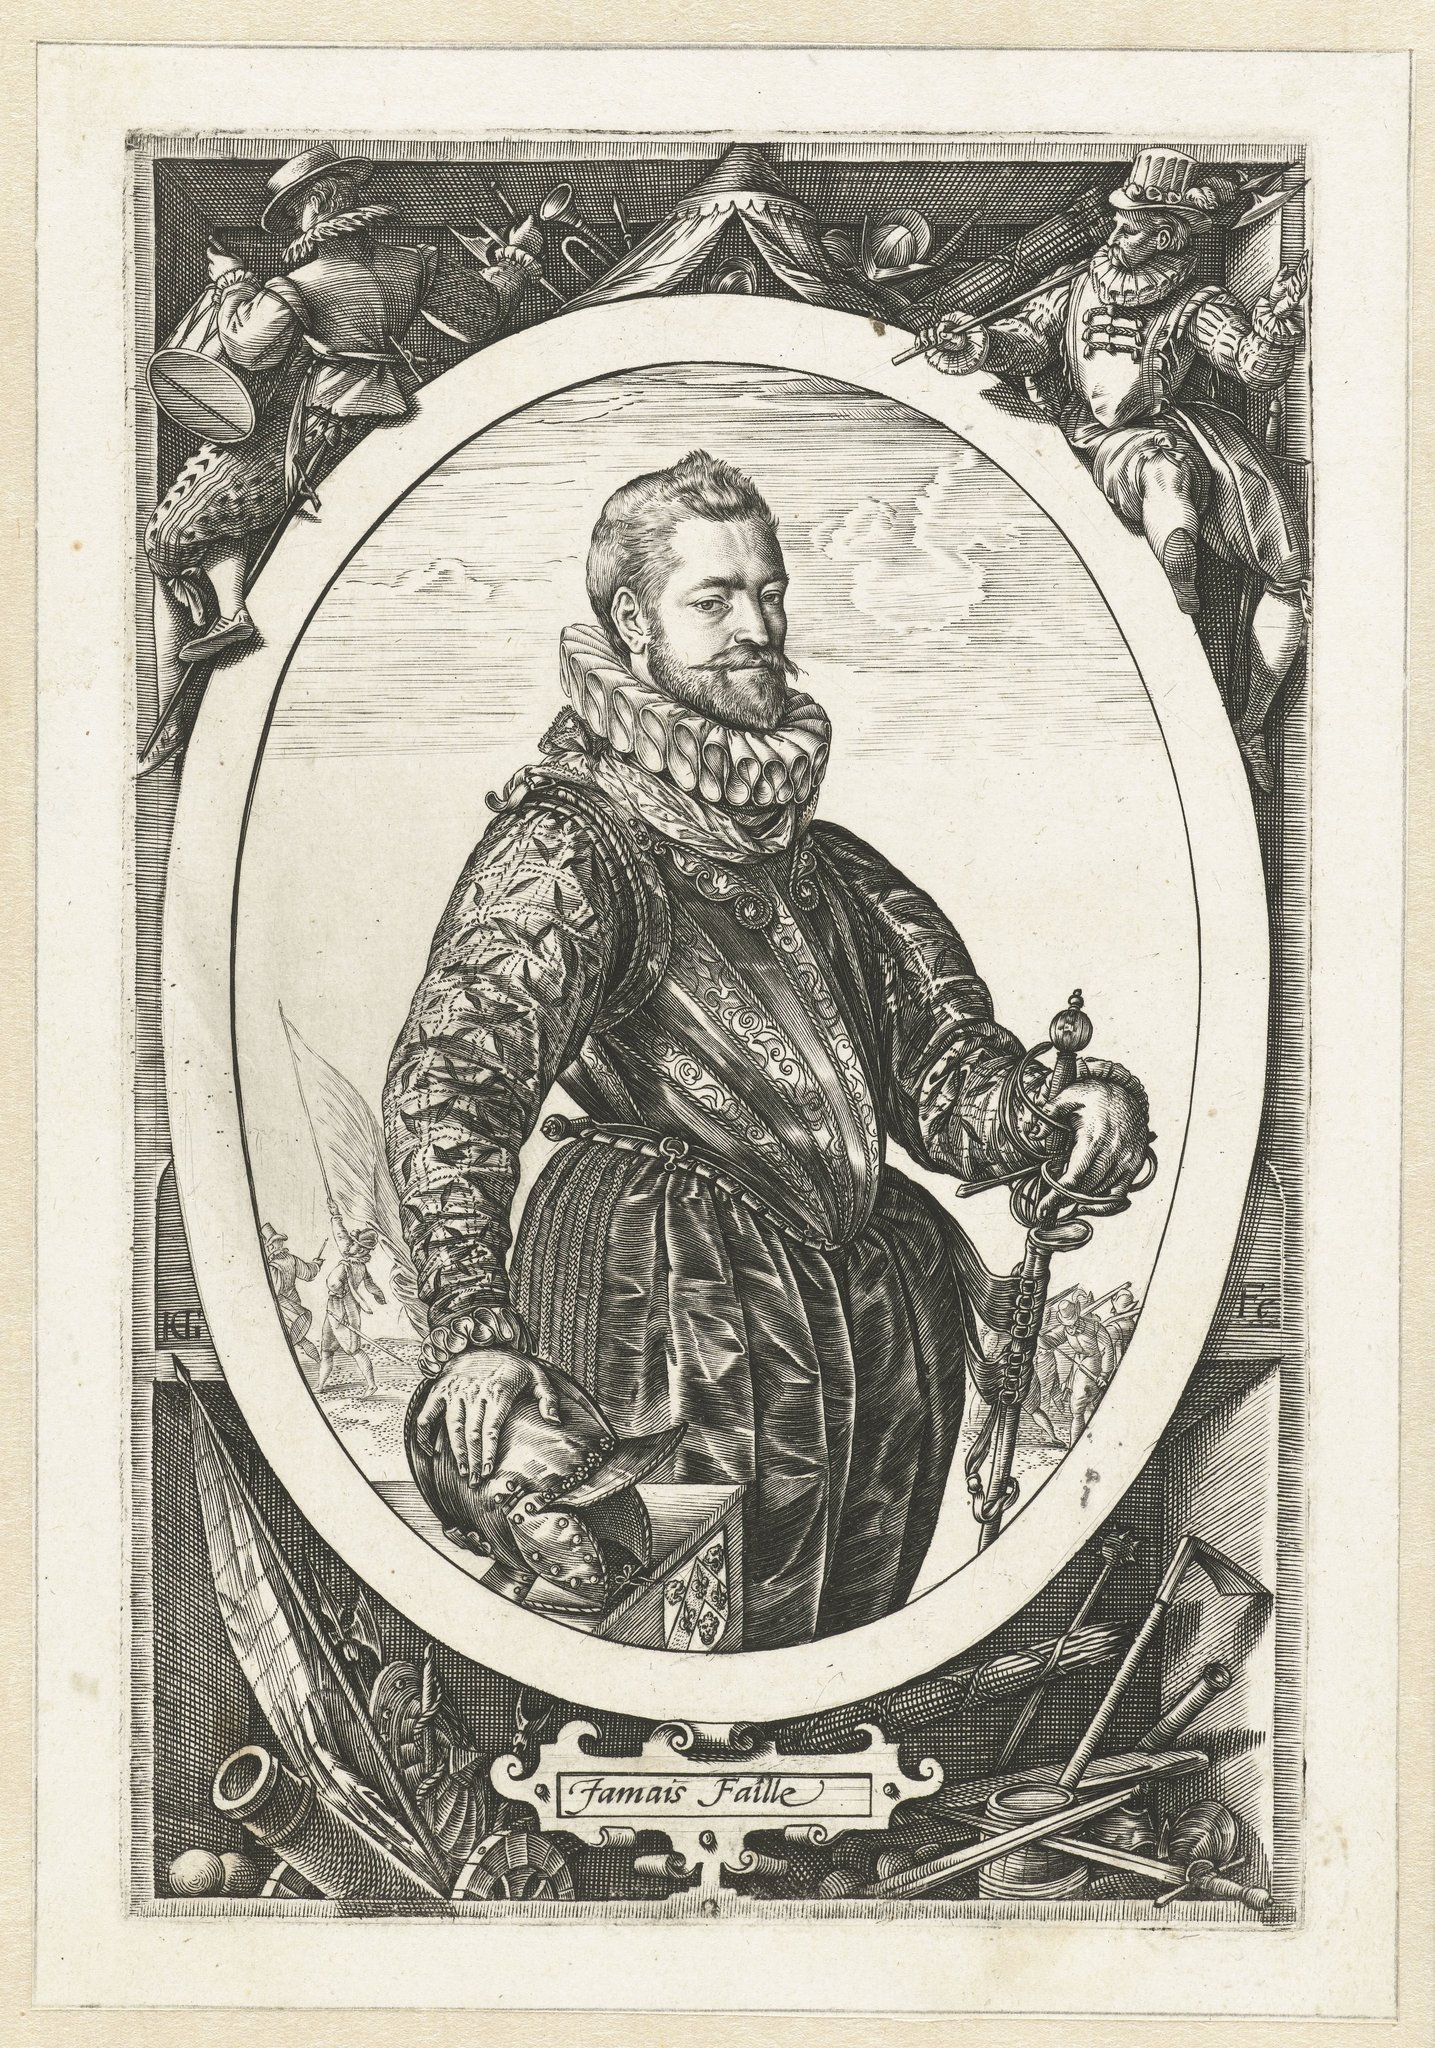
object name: print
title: Jamais Faille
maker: hendrick goltzius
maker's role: draughtsman, painter, print maker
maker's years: 1558-1617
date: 1580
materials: paper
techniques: engraving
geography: haarlem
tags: neck-gear ~ clothing (with name) (+ men's clothes), historical persons, warfare; military affairs (+ citizen soldiery, civil guard, citizen militia), clothing for the upper part of the body (doublet) (+ men's clothes), sleeves (+ men's clothes), merchant, salesman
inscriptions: collector's mark: Lugt 240, signature: ‘HG FE.’, inscription: ‘Jamais Faille’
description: Kleding: wambuis* en kolder,* hoge lubbenkraag* en wijd vallende kniebroek*. Kort kapsel, puntbaardje* en snor*. Ihle p. 20, nr. 50: Jacques de la Faille draagt een kuras, dat verticaal over de borst tot een richel is toegespitst, wat de vorm va de in deze jaren ganzeborst begrijpelijk maakt. Zijn pofbroek is zeer wijd geworden en gaat door tot de knie.